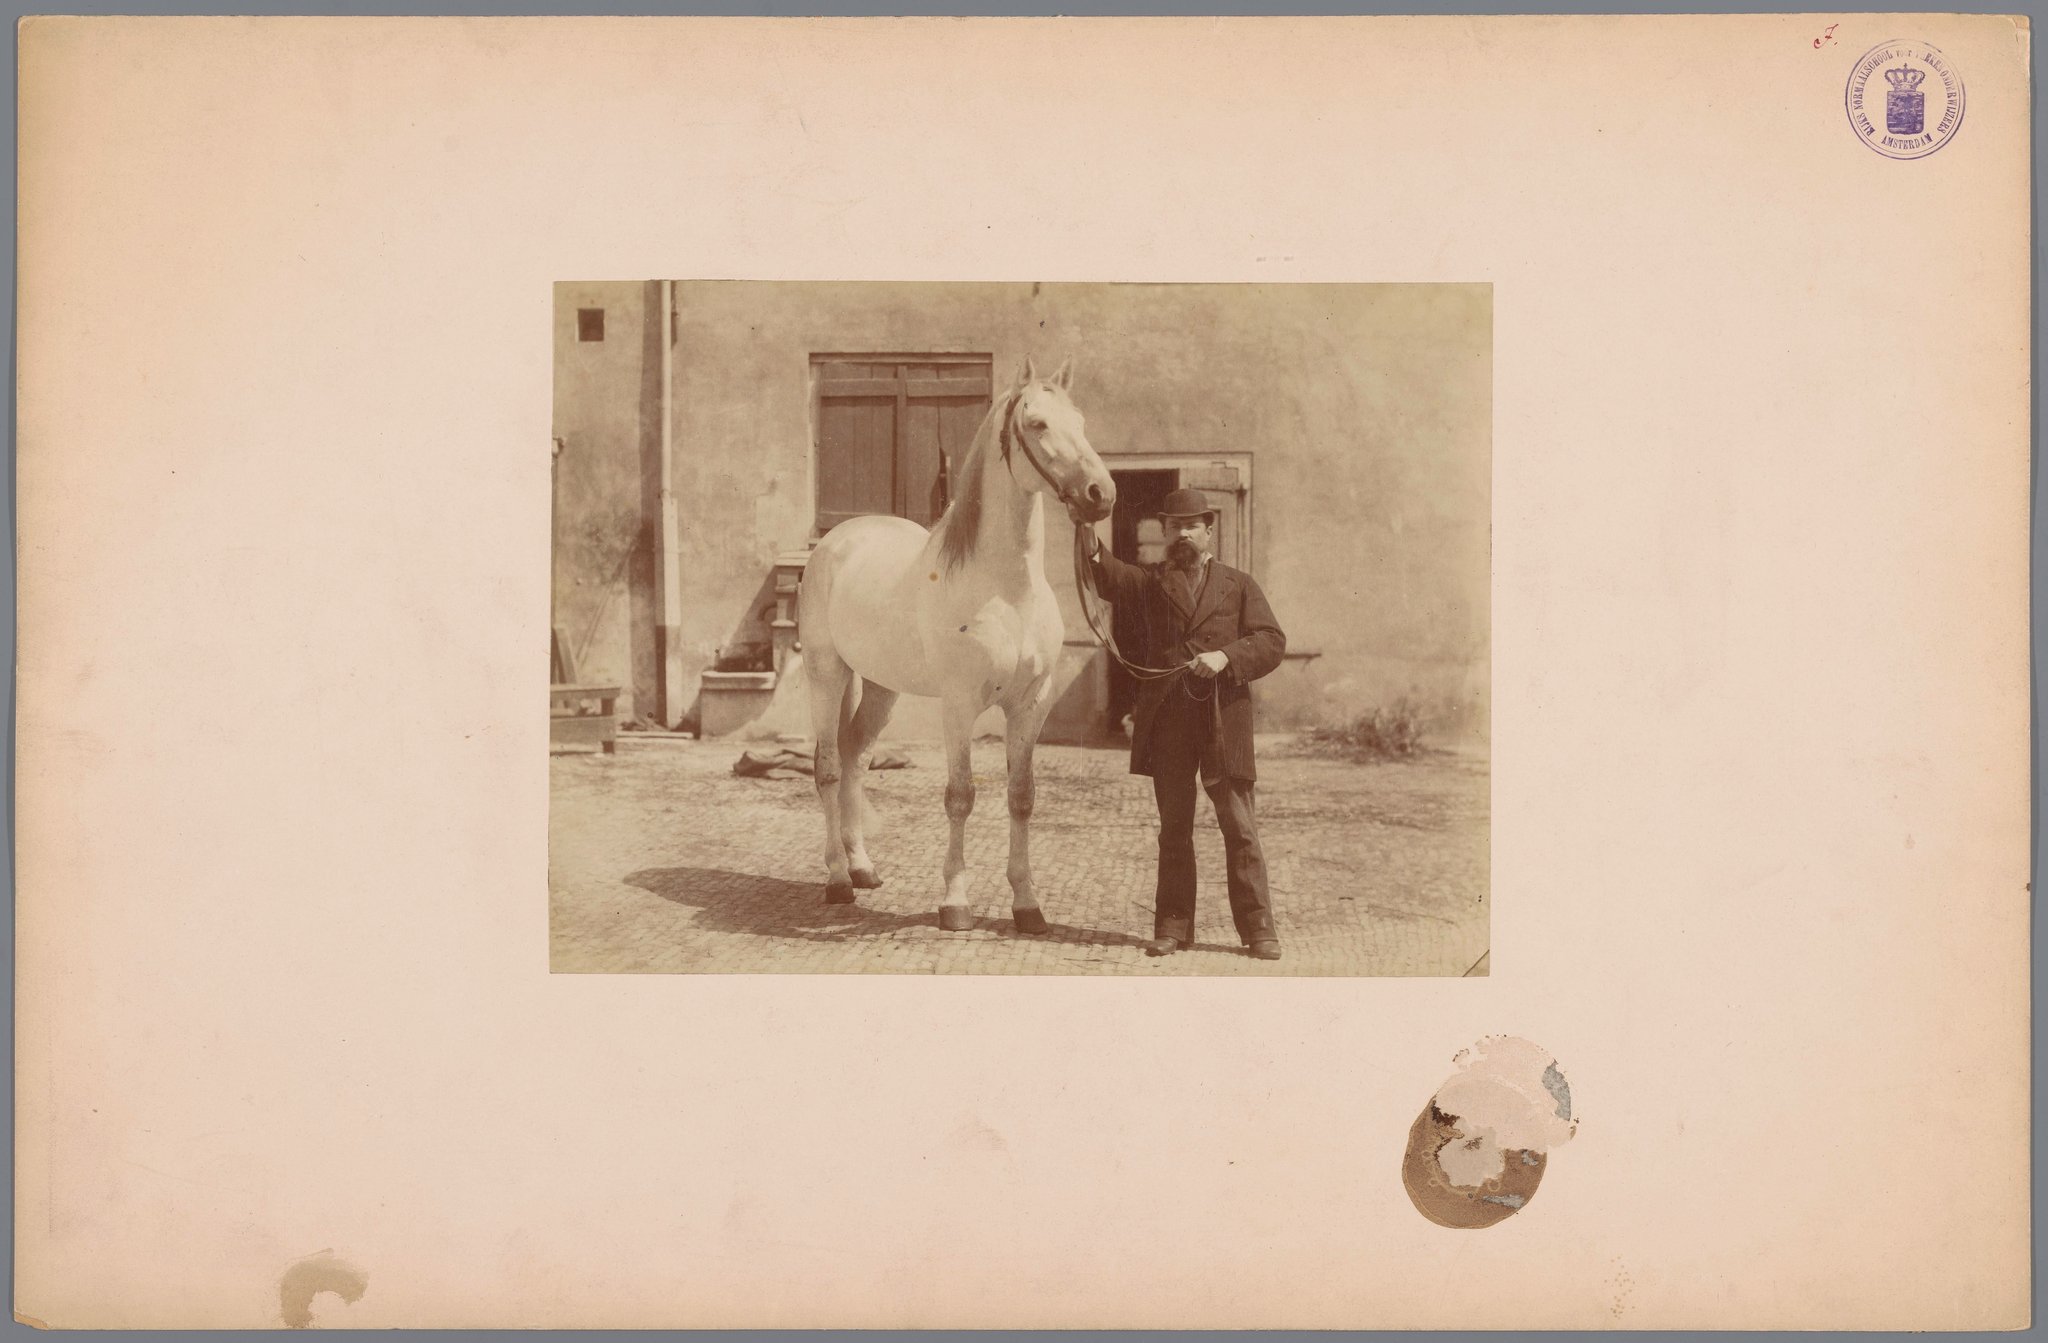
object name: photograph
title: Man met een bolhoed met een wit paard op een binnenplaats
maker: willem frederik vinkenbos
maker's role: fotograaf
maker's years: 1831-1896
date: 1875-1900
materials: cardboard, photographic support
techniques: albumen print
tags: man and animal, head-gear: hat, courtyard, horse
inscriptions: collector's mark: ‘RIJKS NORMAALSCHOOL VOOR TEEKENONDERWIJZERS AMSTERDAM’, inscription: ‘F.’, number: ‘No 5 Hamlet’, name: ‘PHOTOGRAPHIE W.F. VINKENBOS DE RIEMERSTRAAT 111 DEN HAAG’